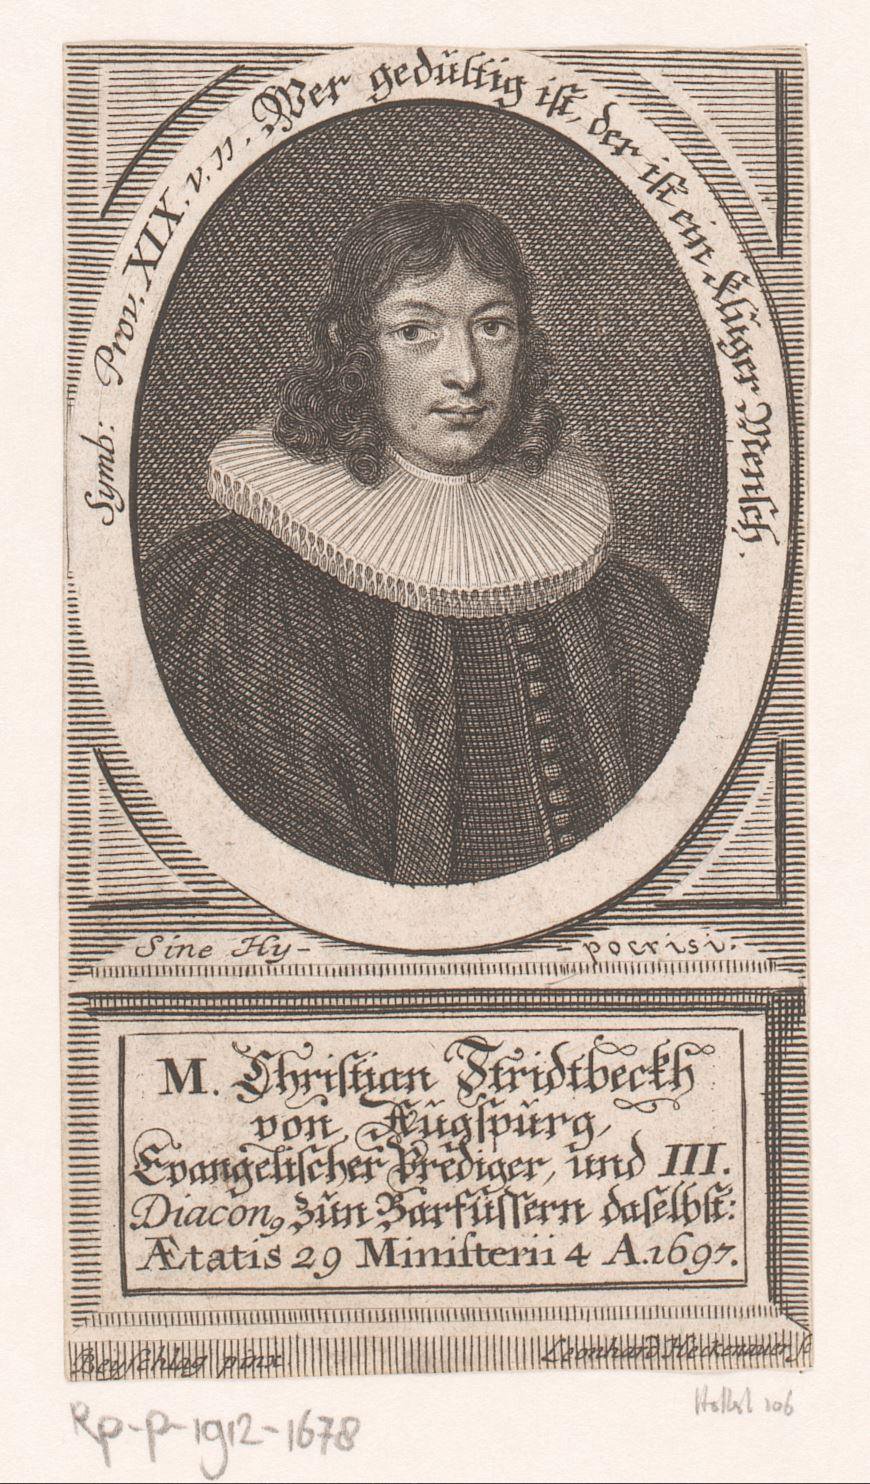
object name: print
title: Portret van Christian Stridtbeckh op 29-jarige leeftijd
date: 1697-1704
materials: paper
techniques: engraving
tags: augsburg, historical persons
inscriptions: collector's mark: Lugt 2228